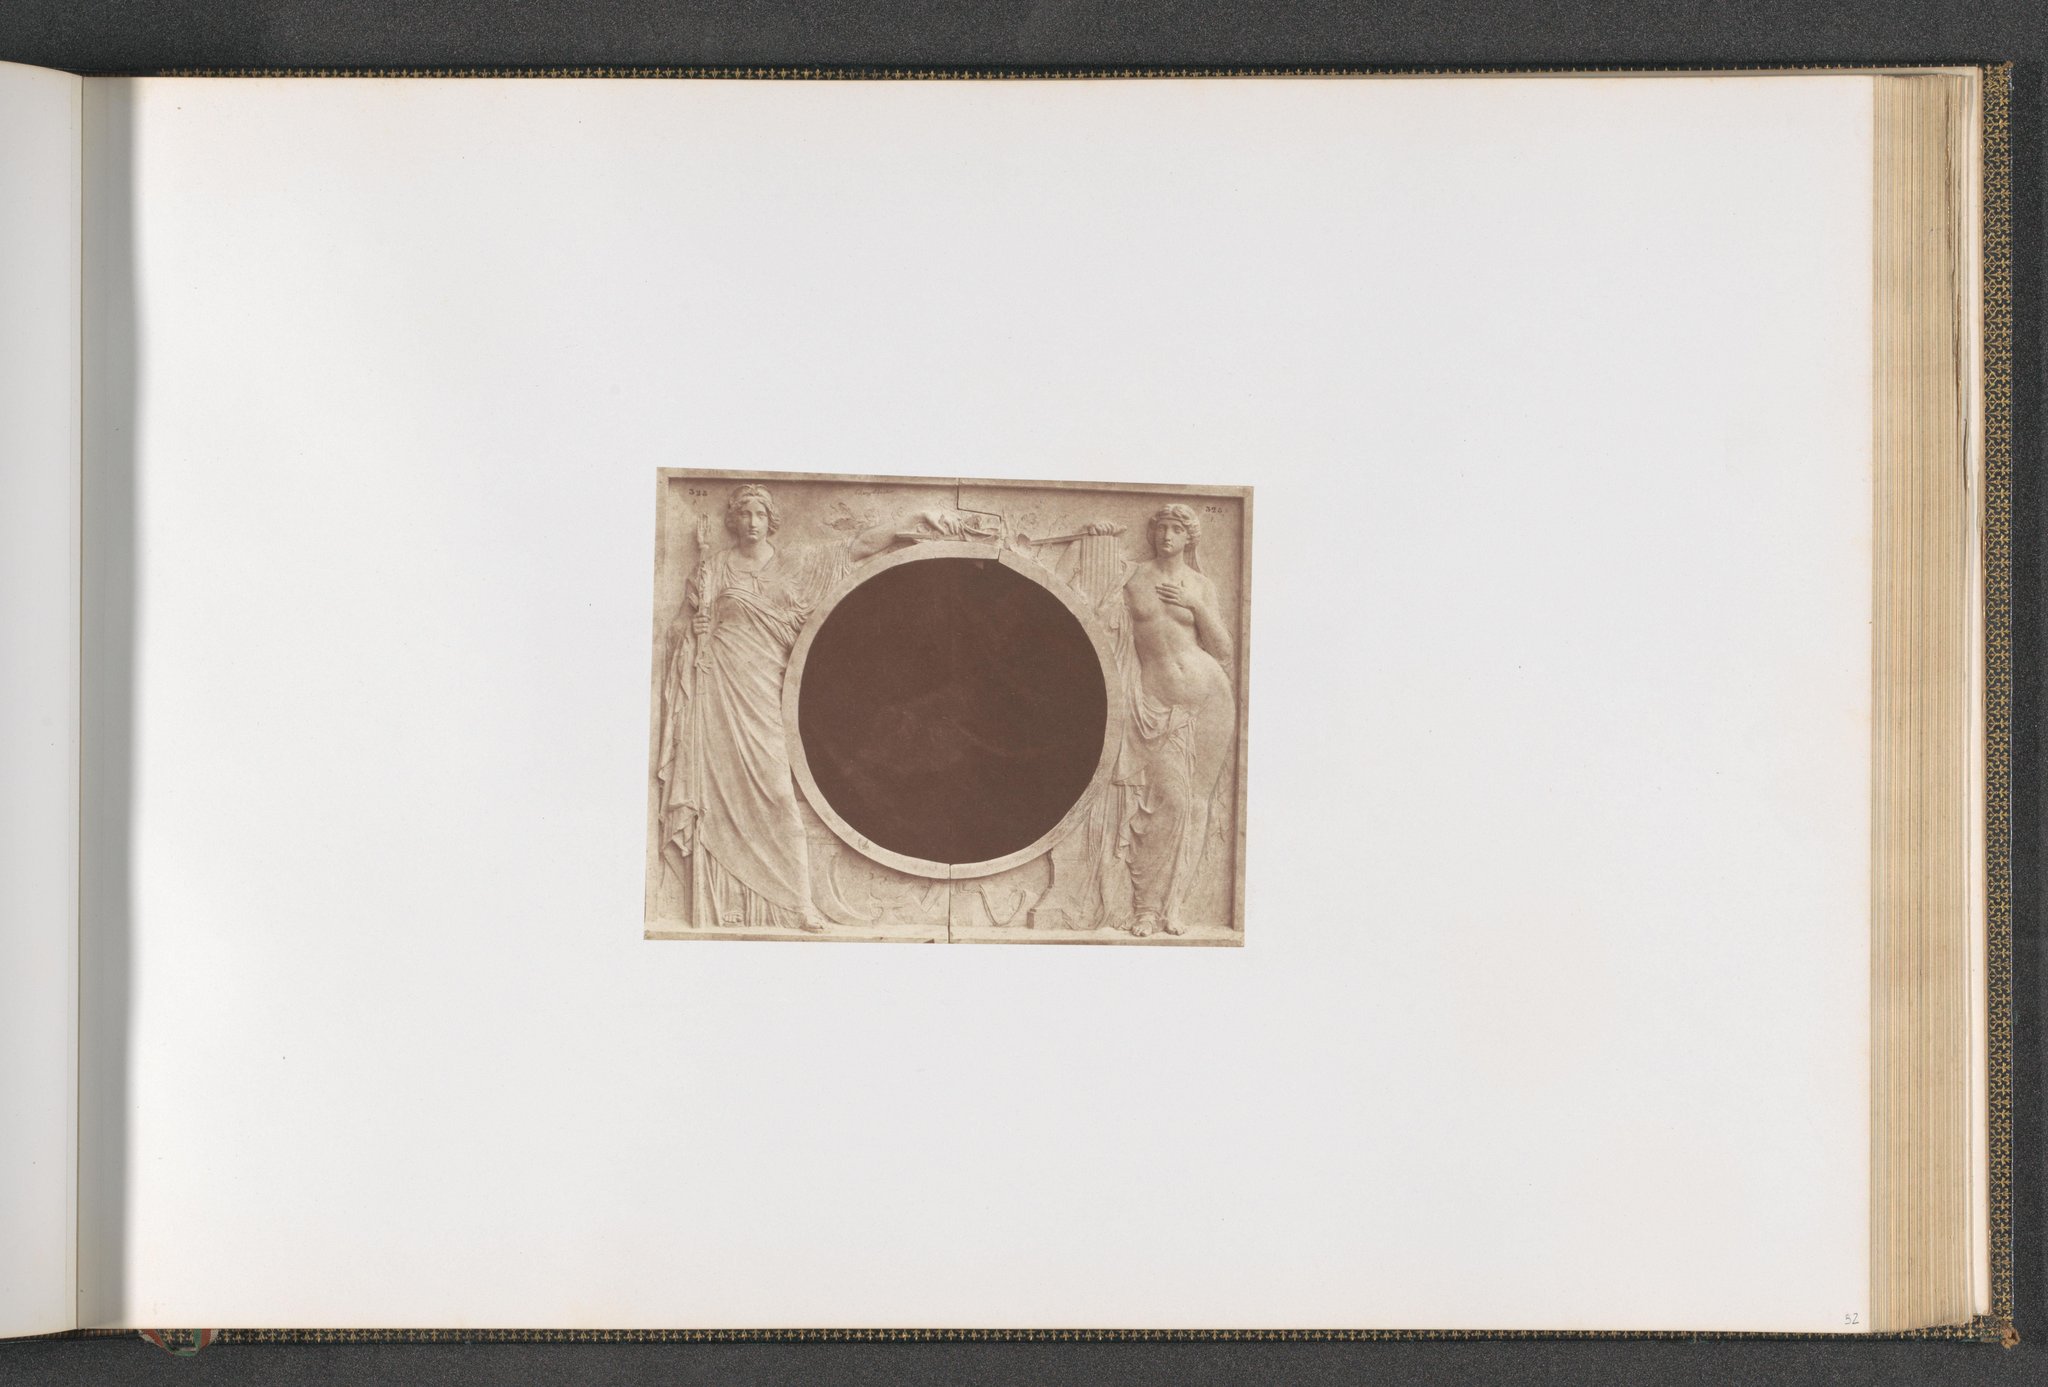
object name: album leaf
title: Gipsmodellen voor beeldhouwwerken op het Palais du Louvre: "La Prudence et la Force" door Victor Edmond Leharivel-Durocher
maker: édouard denis baldus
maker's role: fotograaf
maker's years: 1813-1889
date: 1855-1857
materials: paper, photographic support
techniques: salted paper print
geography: paris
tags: piece of sculpture, reproduction of a piece of sculpture, permanent exhibition, museum, paris, tuileries palace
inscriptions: number: ‘328’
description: Onderdeel van Réunion des Tuileries au Louvre 1852-1857, album 2.